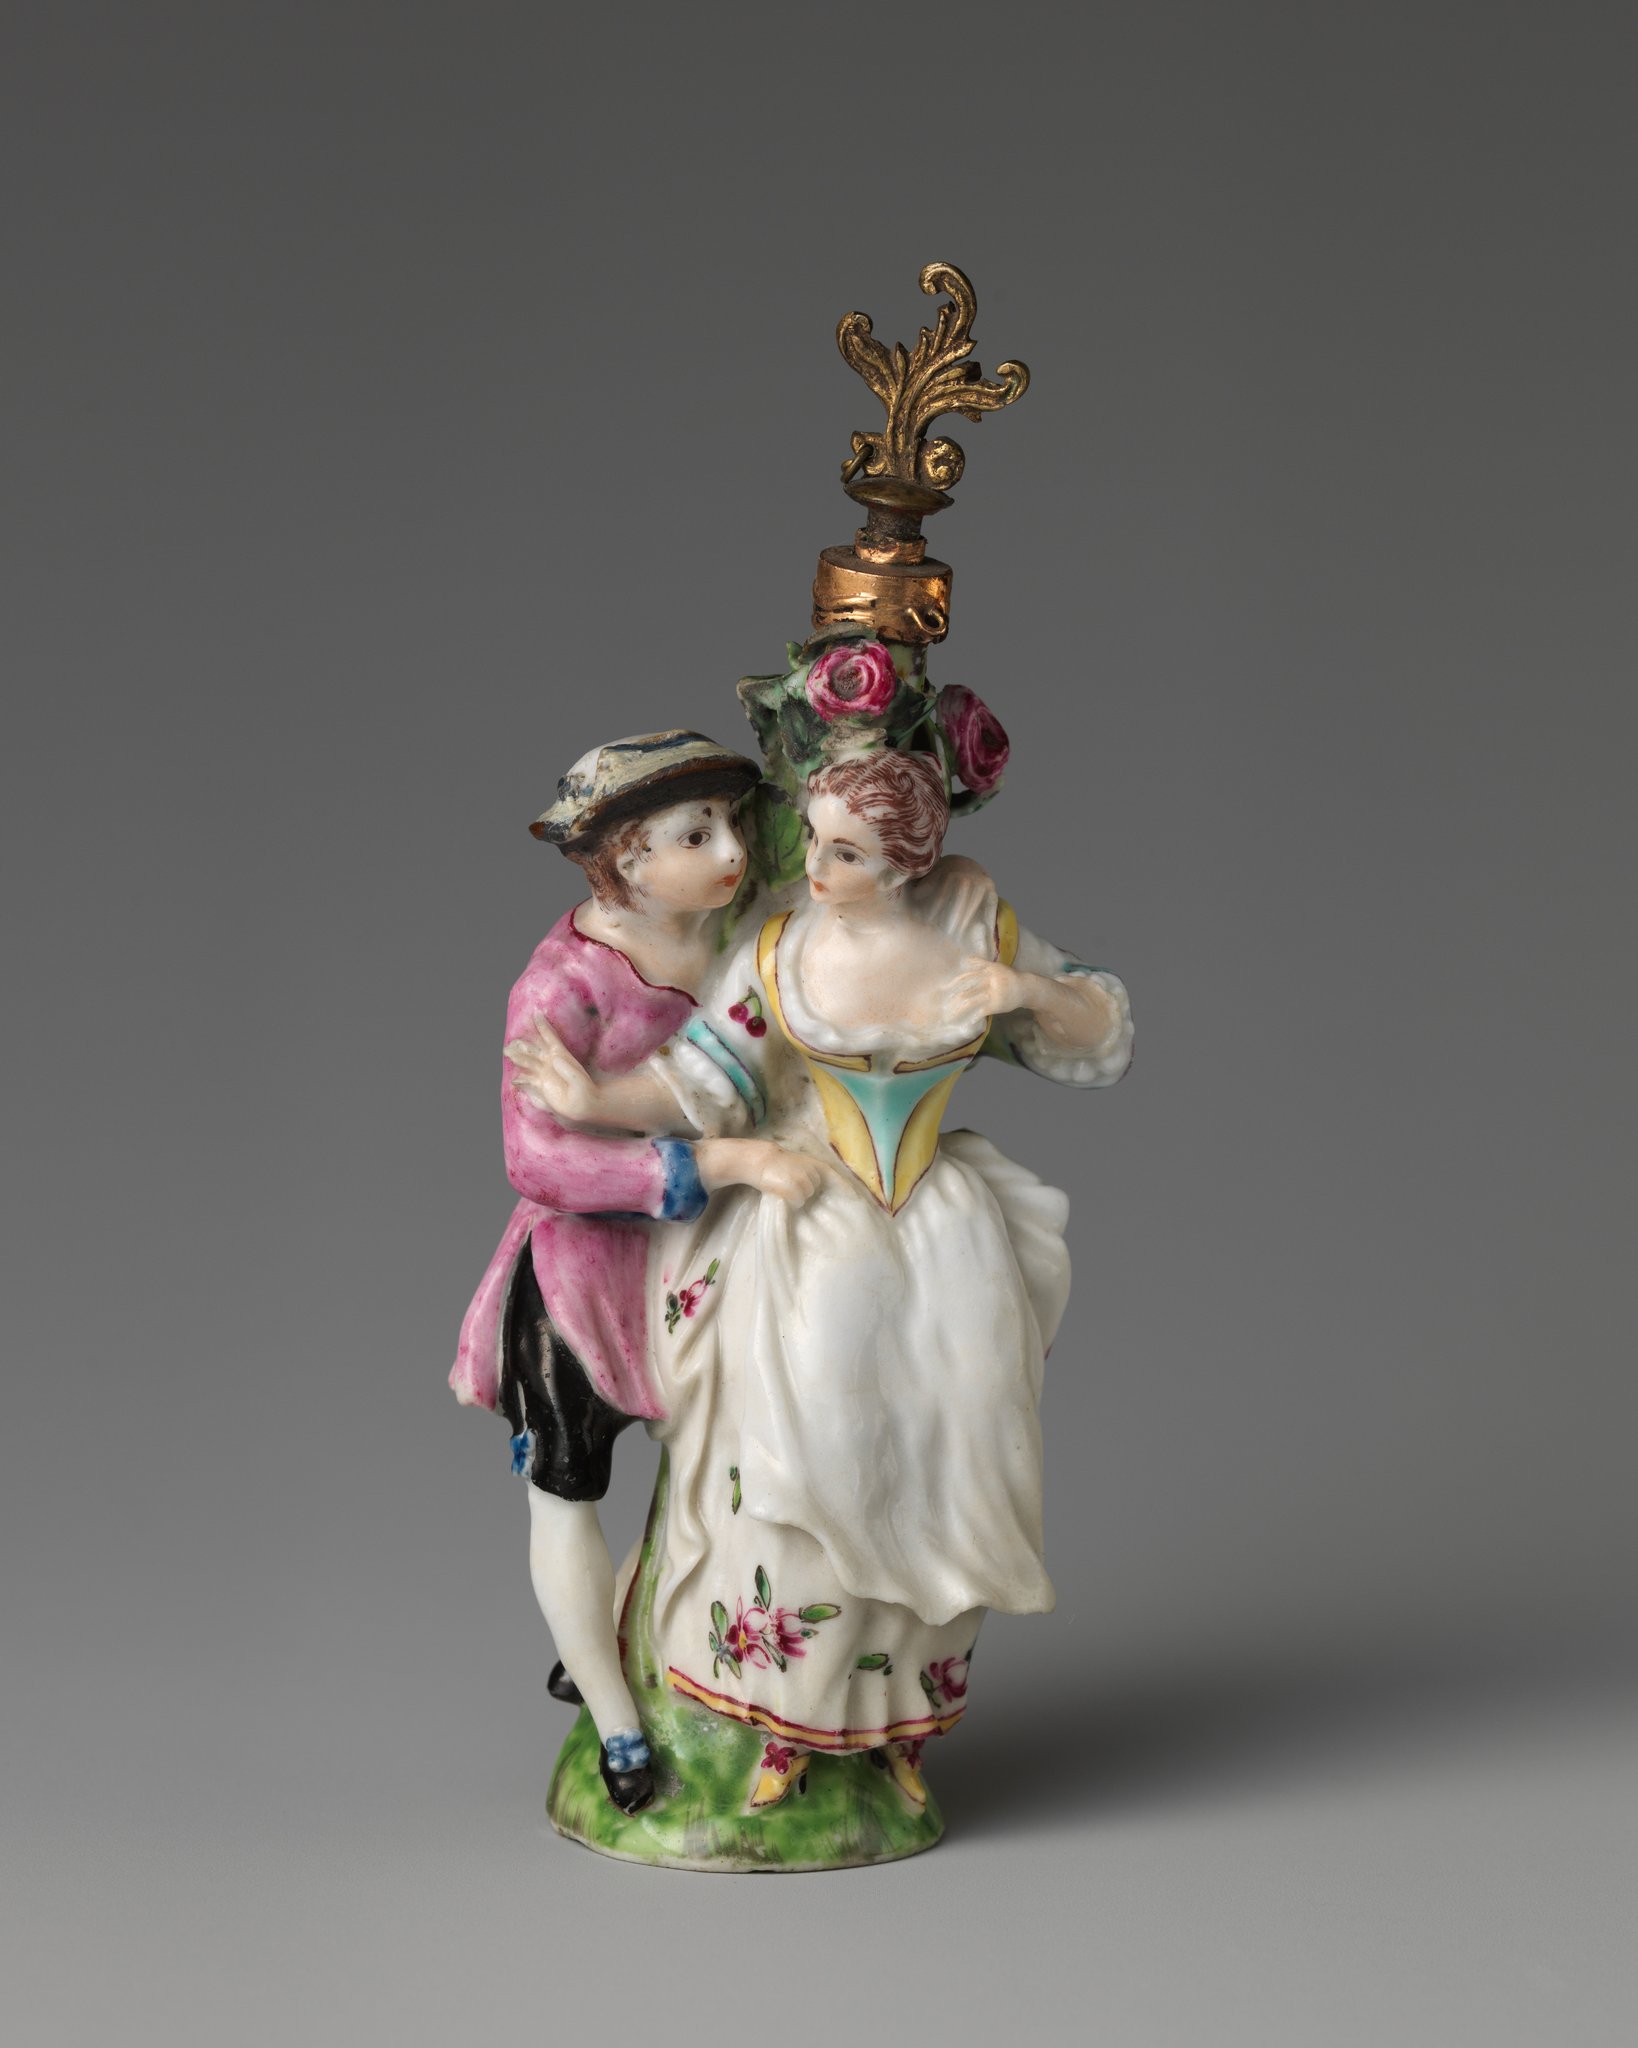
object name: toy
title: Two lovers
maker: saint james's factory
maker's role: maker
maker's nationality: british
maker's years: 1749-1759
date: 1750-1755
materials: soft paste porcelain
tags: men,lovers,women